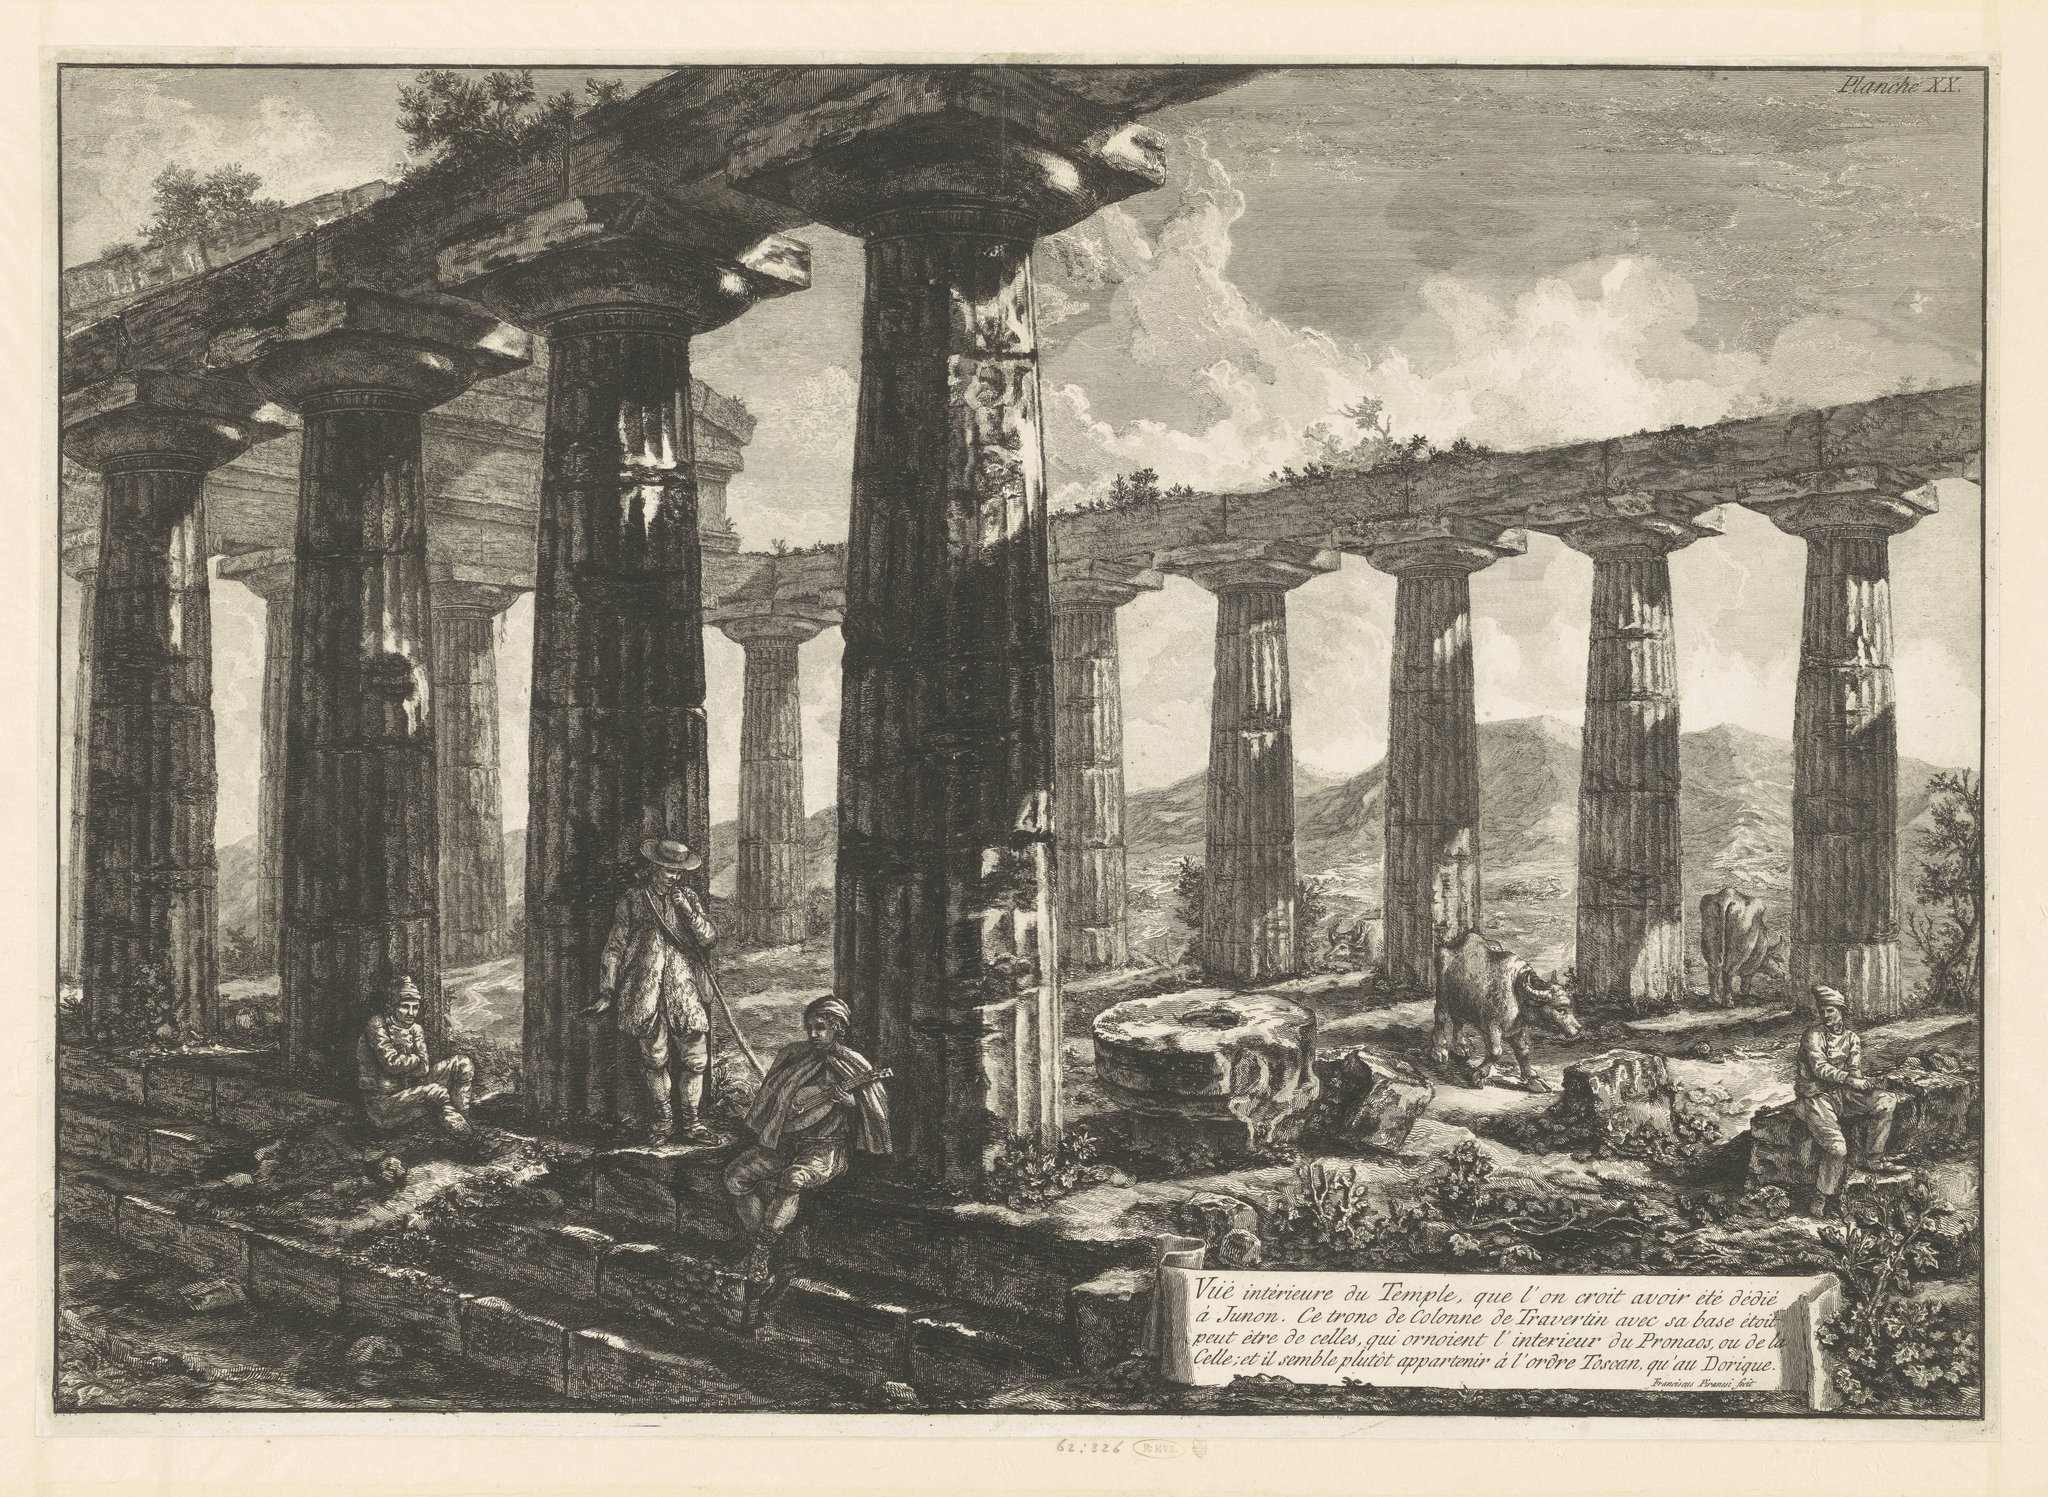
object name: print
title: Différentes vues de quelques restes de trois grands édifices qui subsistent encore dans l'ancienne ville de Pesto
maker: francesco piranesi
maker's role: print maker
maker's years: 1758-1810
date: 1778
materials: paper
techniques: etching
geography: rome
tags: ruin of a building ~ architecture, landscape with ruins, temple, shrine ~ roman religion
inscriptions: collector's mark: Lugt 2228, collector's mark: Lugt 2760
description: Deze prent maakt deel uit van een reeks van 20 prenten (+ titelprent) met gezichten op tempels te Paestum. De gebouwen en de vegetatie op de prenten zijn uitgevoerd door Giovanni Battista Piranesi. De figuren zijn mogelijk uitgevoerd door zijn zoon Francesco.